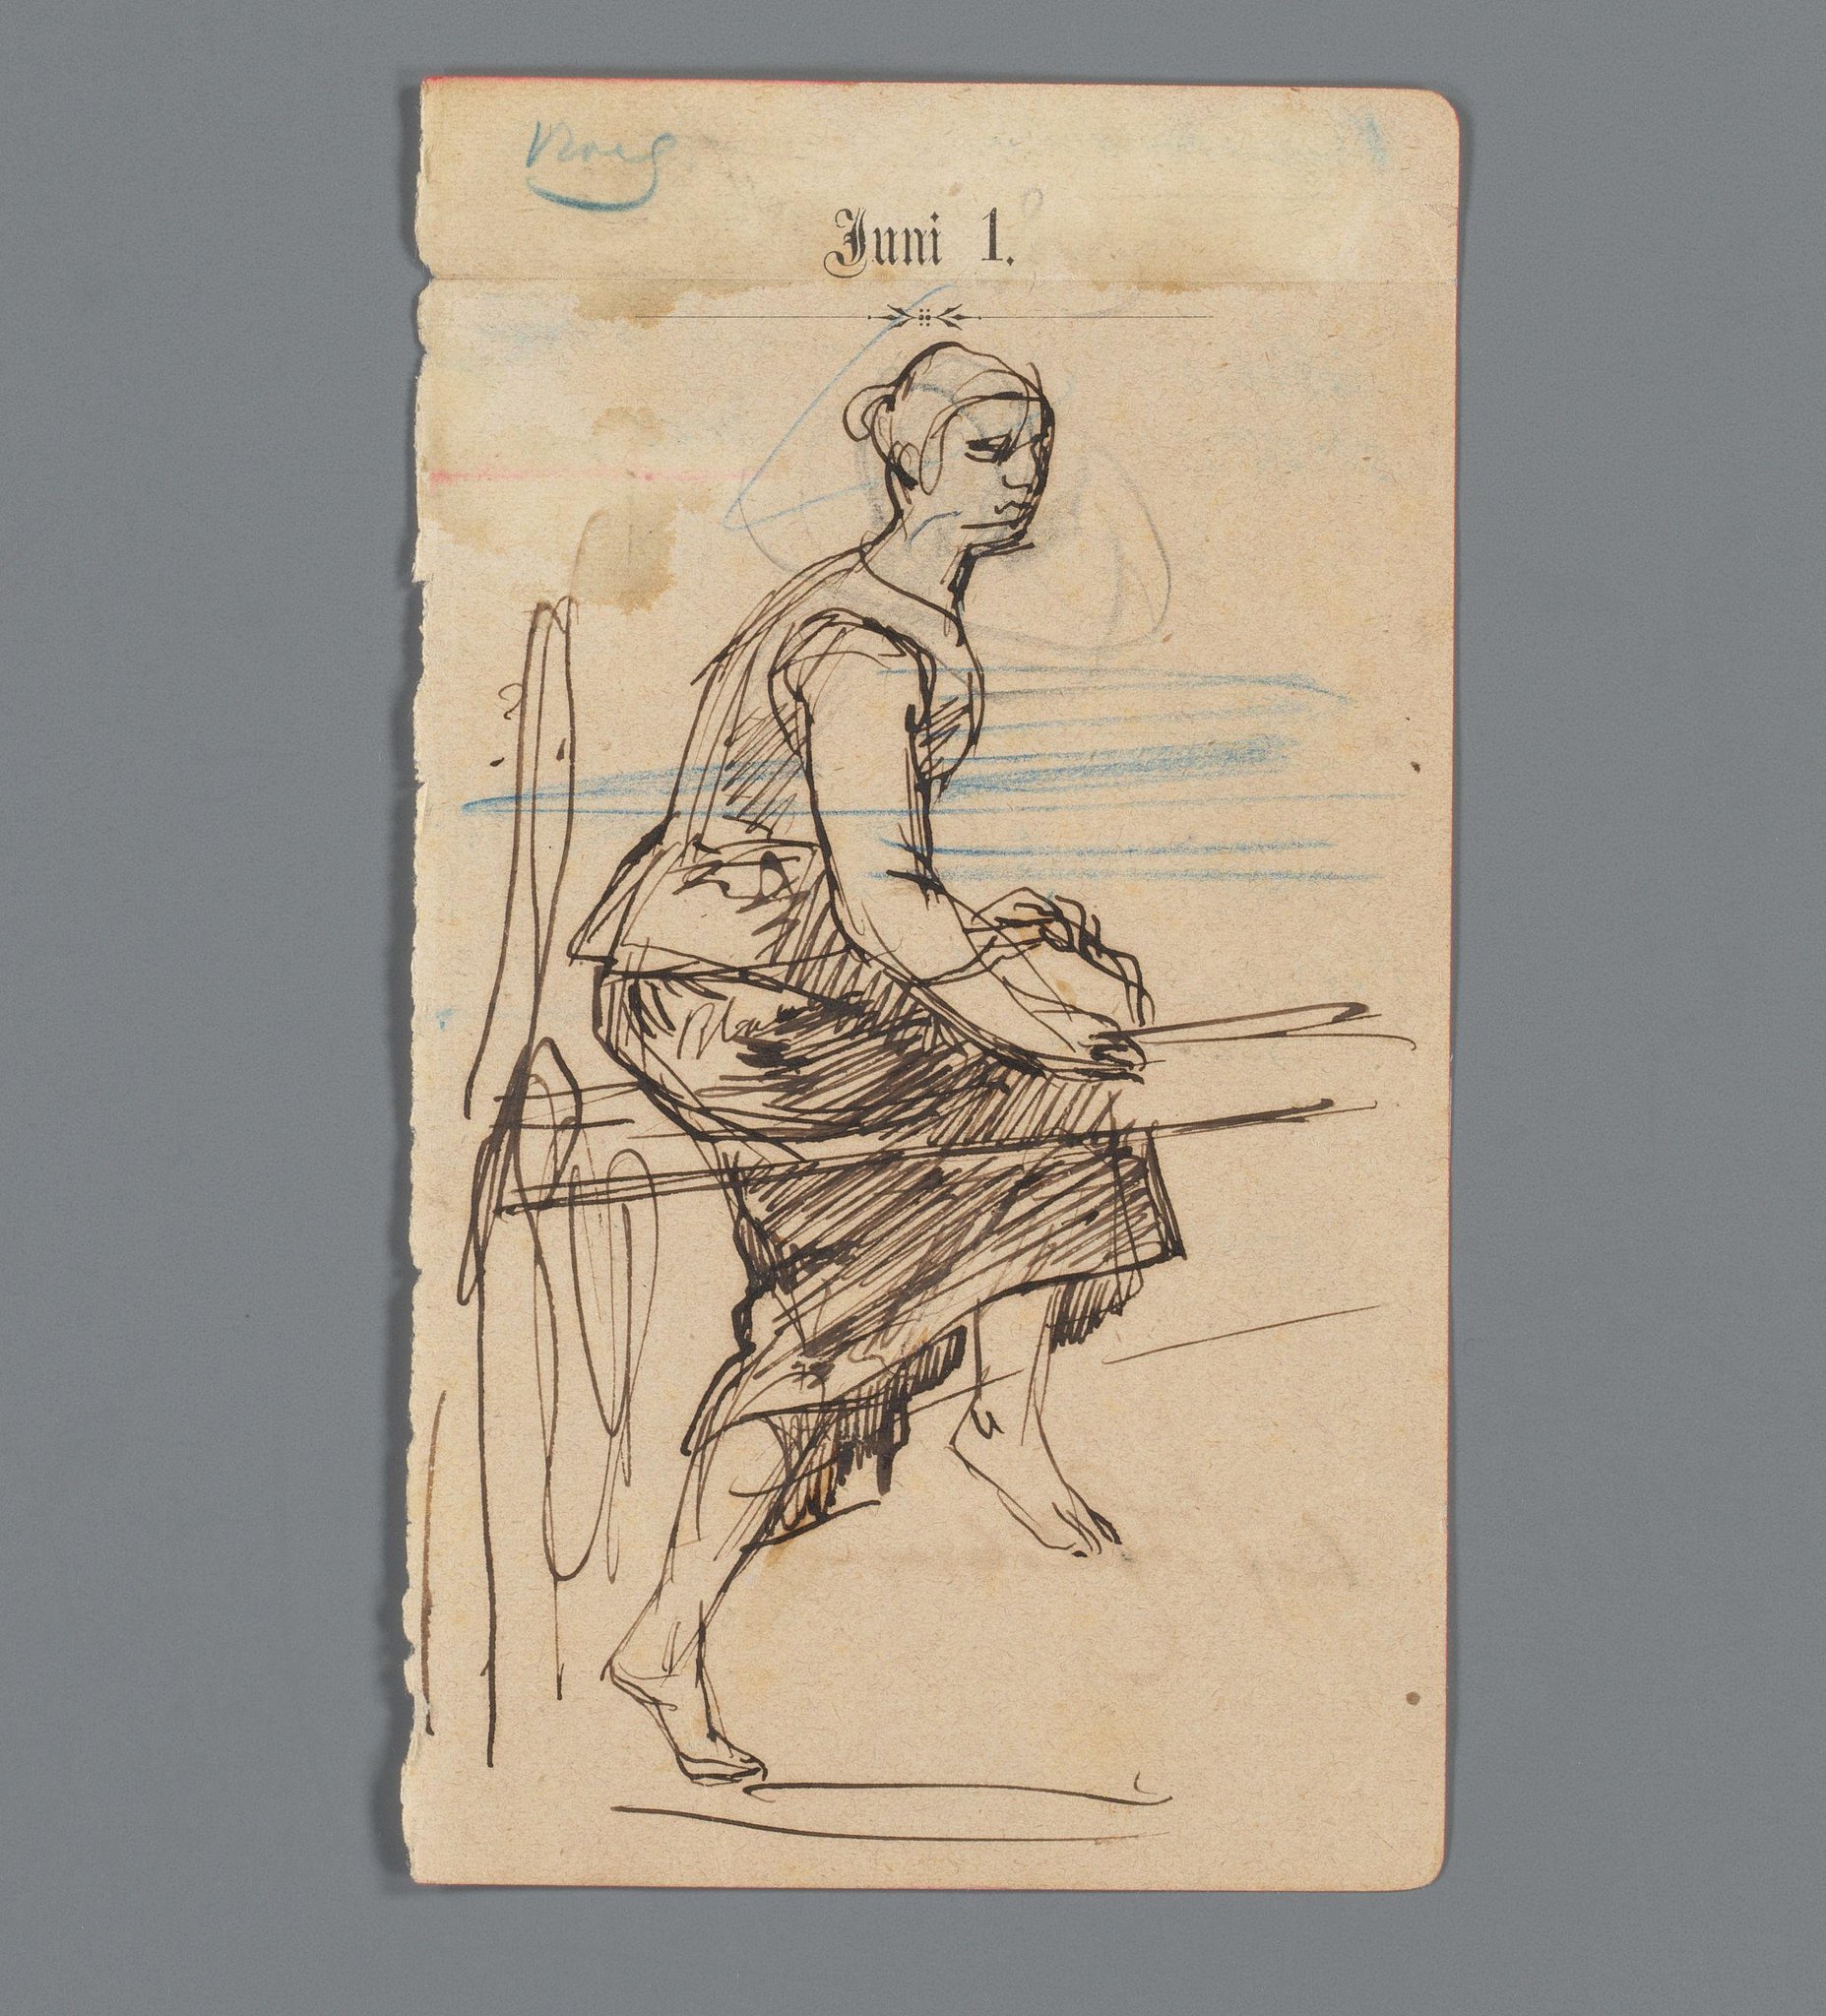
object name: drawing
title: Schets van een zittende vrouw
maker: august allebé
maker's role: draughtsman, print maker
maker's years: 1838-1927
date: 1848-1927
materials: ink, paper, pencil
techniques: pen